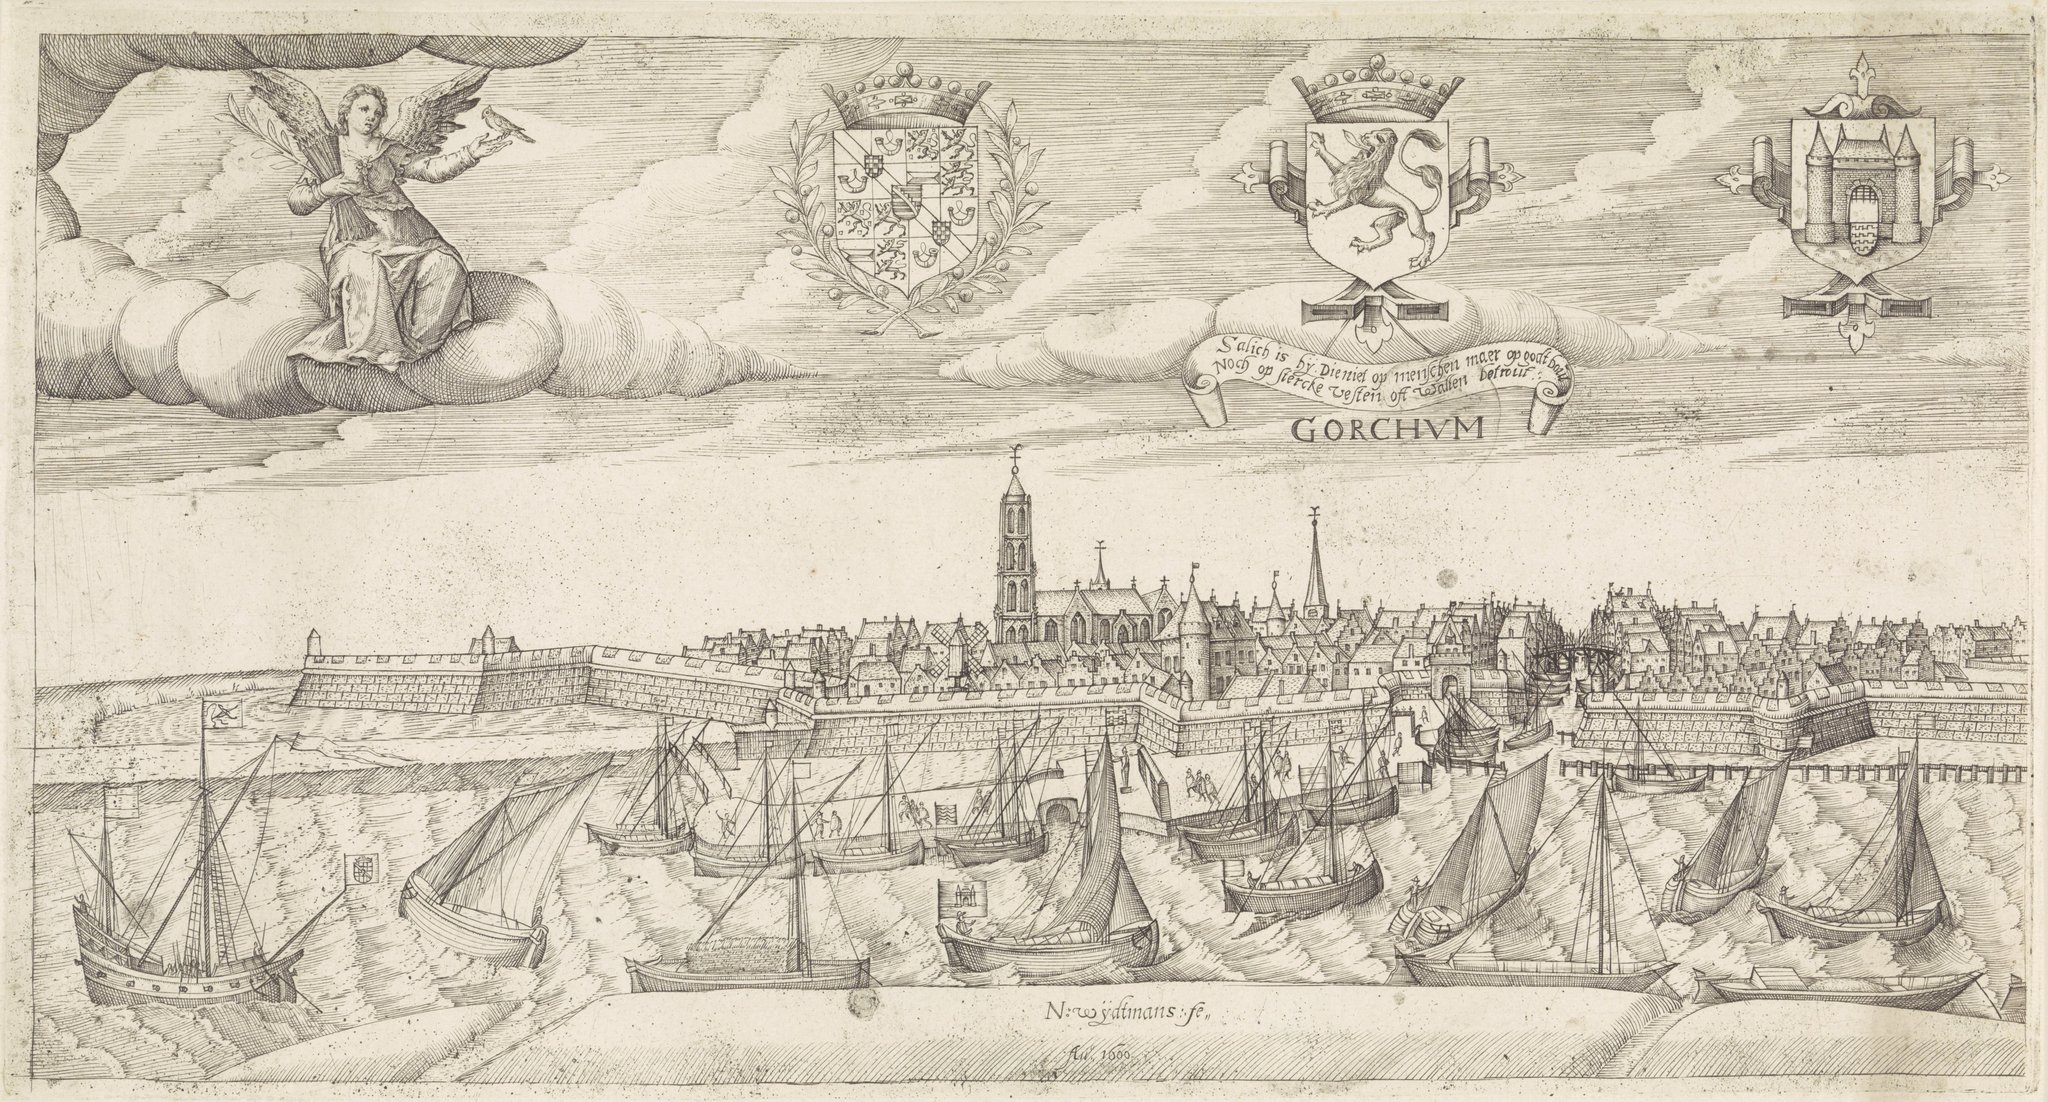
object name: print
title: Gezicht op de stad Gorinchem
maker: nicolaes weydtmans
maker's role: print maker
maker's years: 1570-1642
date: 1600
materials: paper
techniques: engraving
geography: gorinchem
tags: city-view in general; 'veduta'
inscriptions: collector's mark: Lugt 2228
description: Gezicht op de stad Gorinchem. Op de voorgrond de Merwede met verschillende schepen. Linksboven zit een engel op de wolken met een pijlenbundel en een oranjetak onder de arm en een vogel op de hand. Midden links het wapen van prins Maurits, midden rechts het wapen van Holland en rechts het stadswapen van Gorinchem. Onder het wapen van Holland hangt een banderol met het volgende tweeregelige opschrift: Salich is hij Die niet op menschen maer op godt bout. Noch op stercke vesten oft wallen betrout.